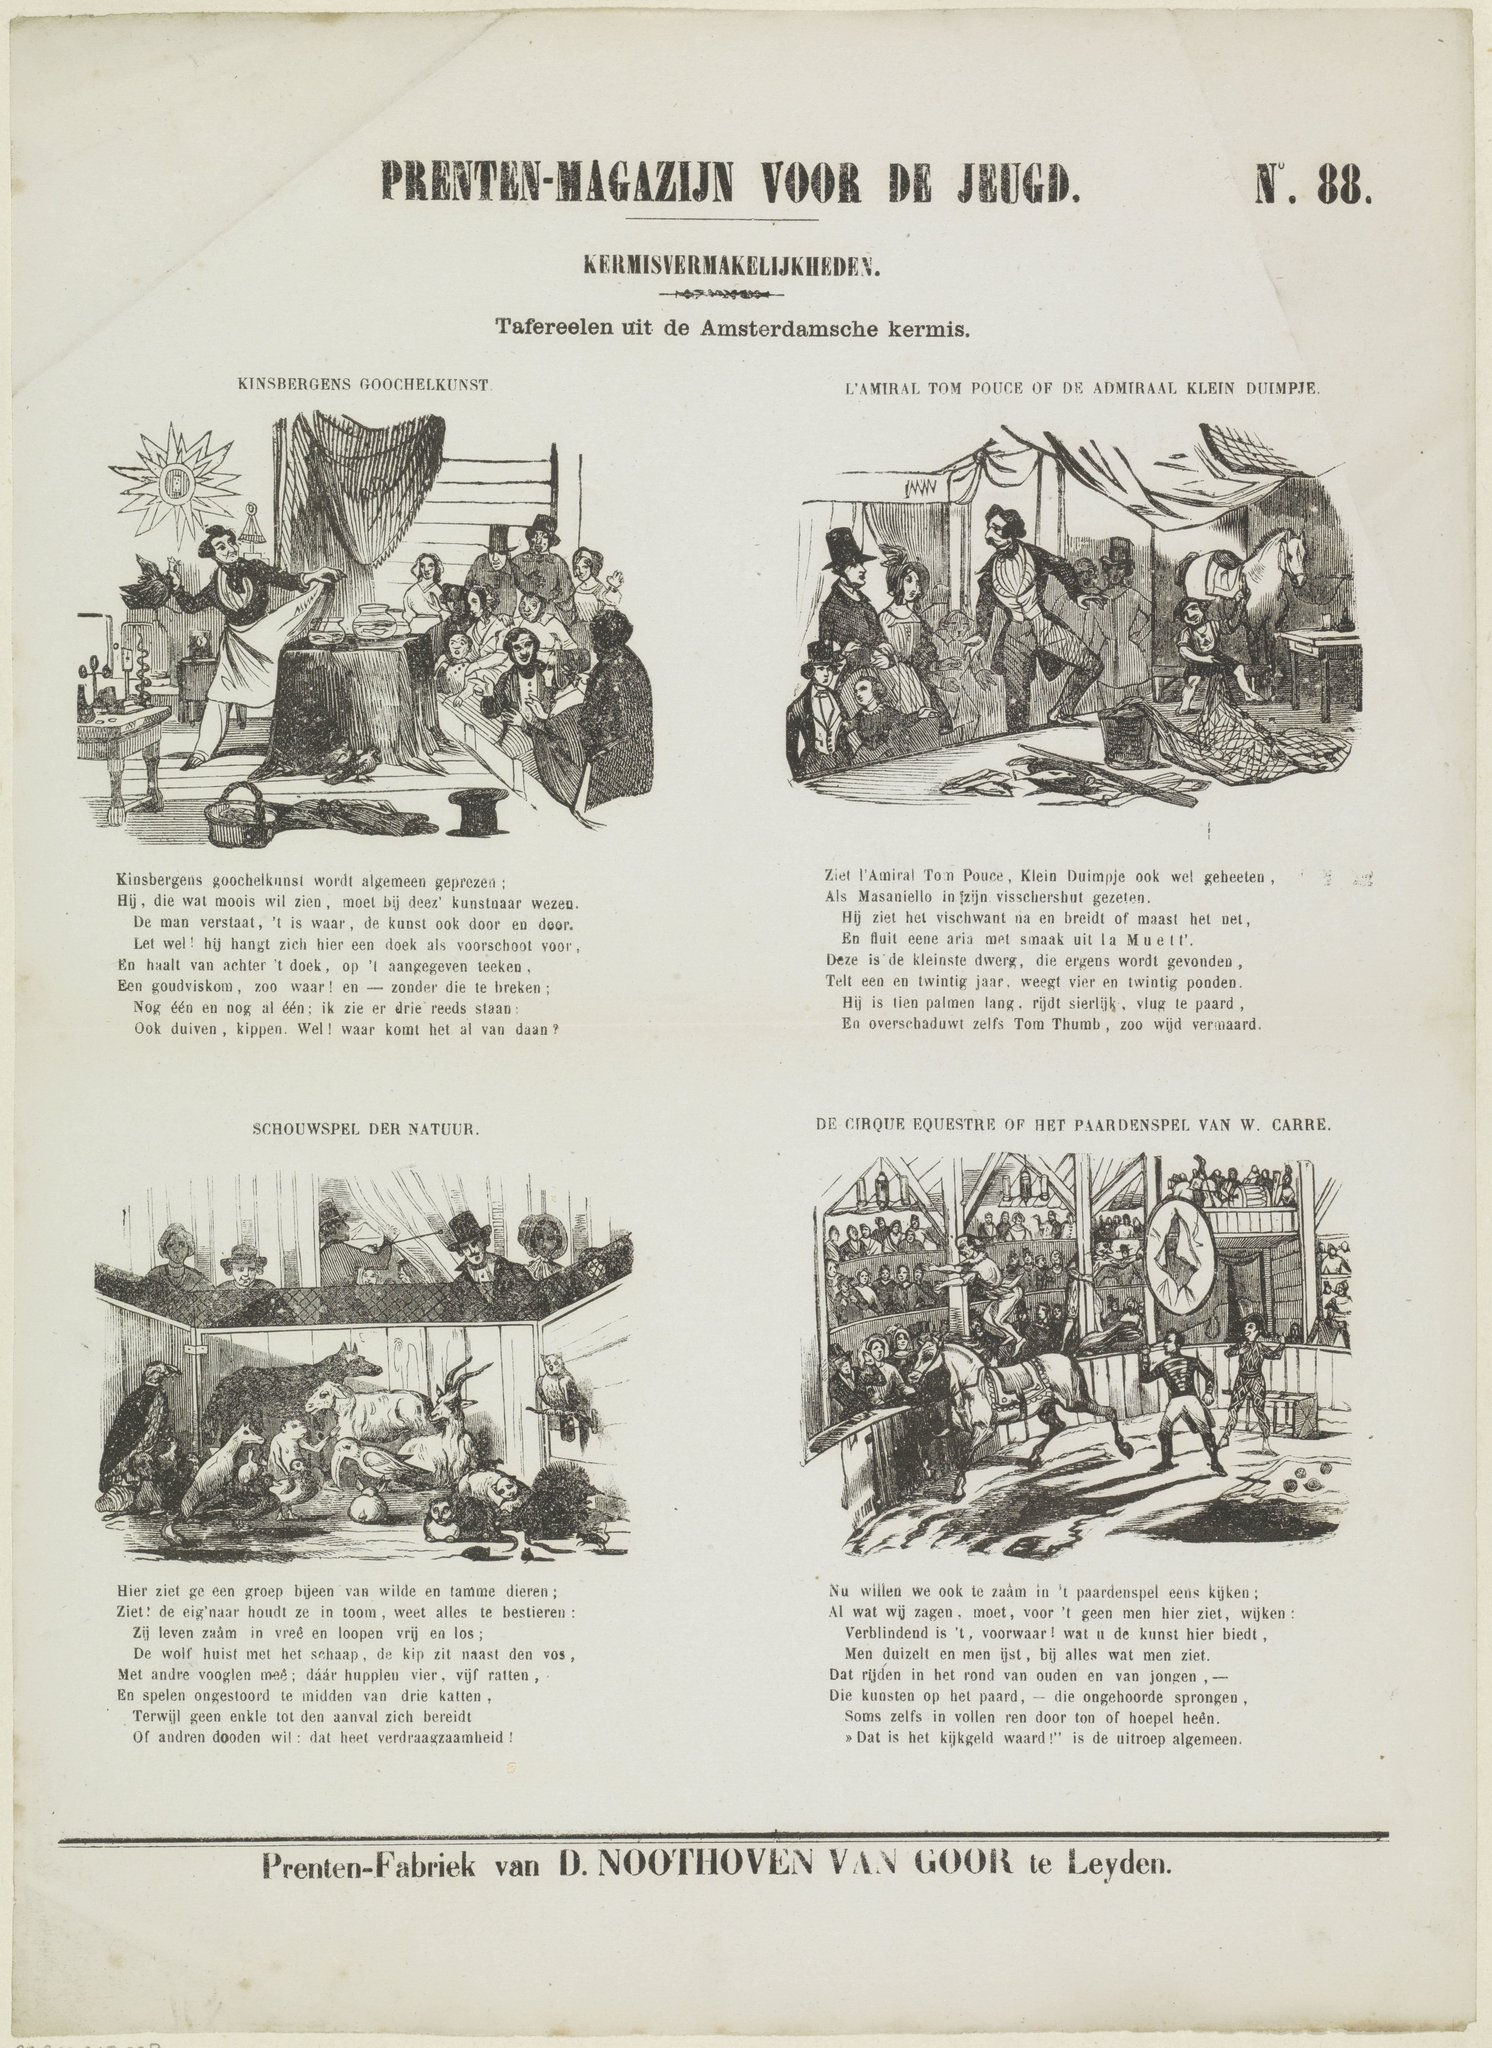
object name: print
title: Kermisvermakelijkheden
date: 1850-1881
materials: paper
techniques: letterpress printing, engraving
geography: netherlands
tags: circus animals, sorcerer, magician, wizard, warlock, circus, horses (circus performance)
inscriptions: collector's mark: Lugt 2760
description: Blad met 4 circustaferelen, zoals een goochelaar en acrobaten te paard. Boven elke voorstelling een titel en onder elke voorstelling een achtregelig vers. Genummerd rechtsboven: No. 88.